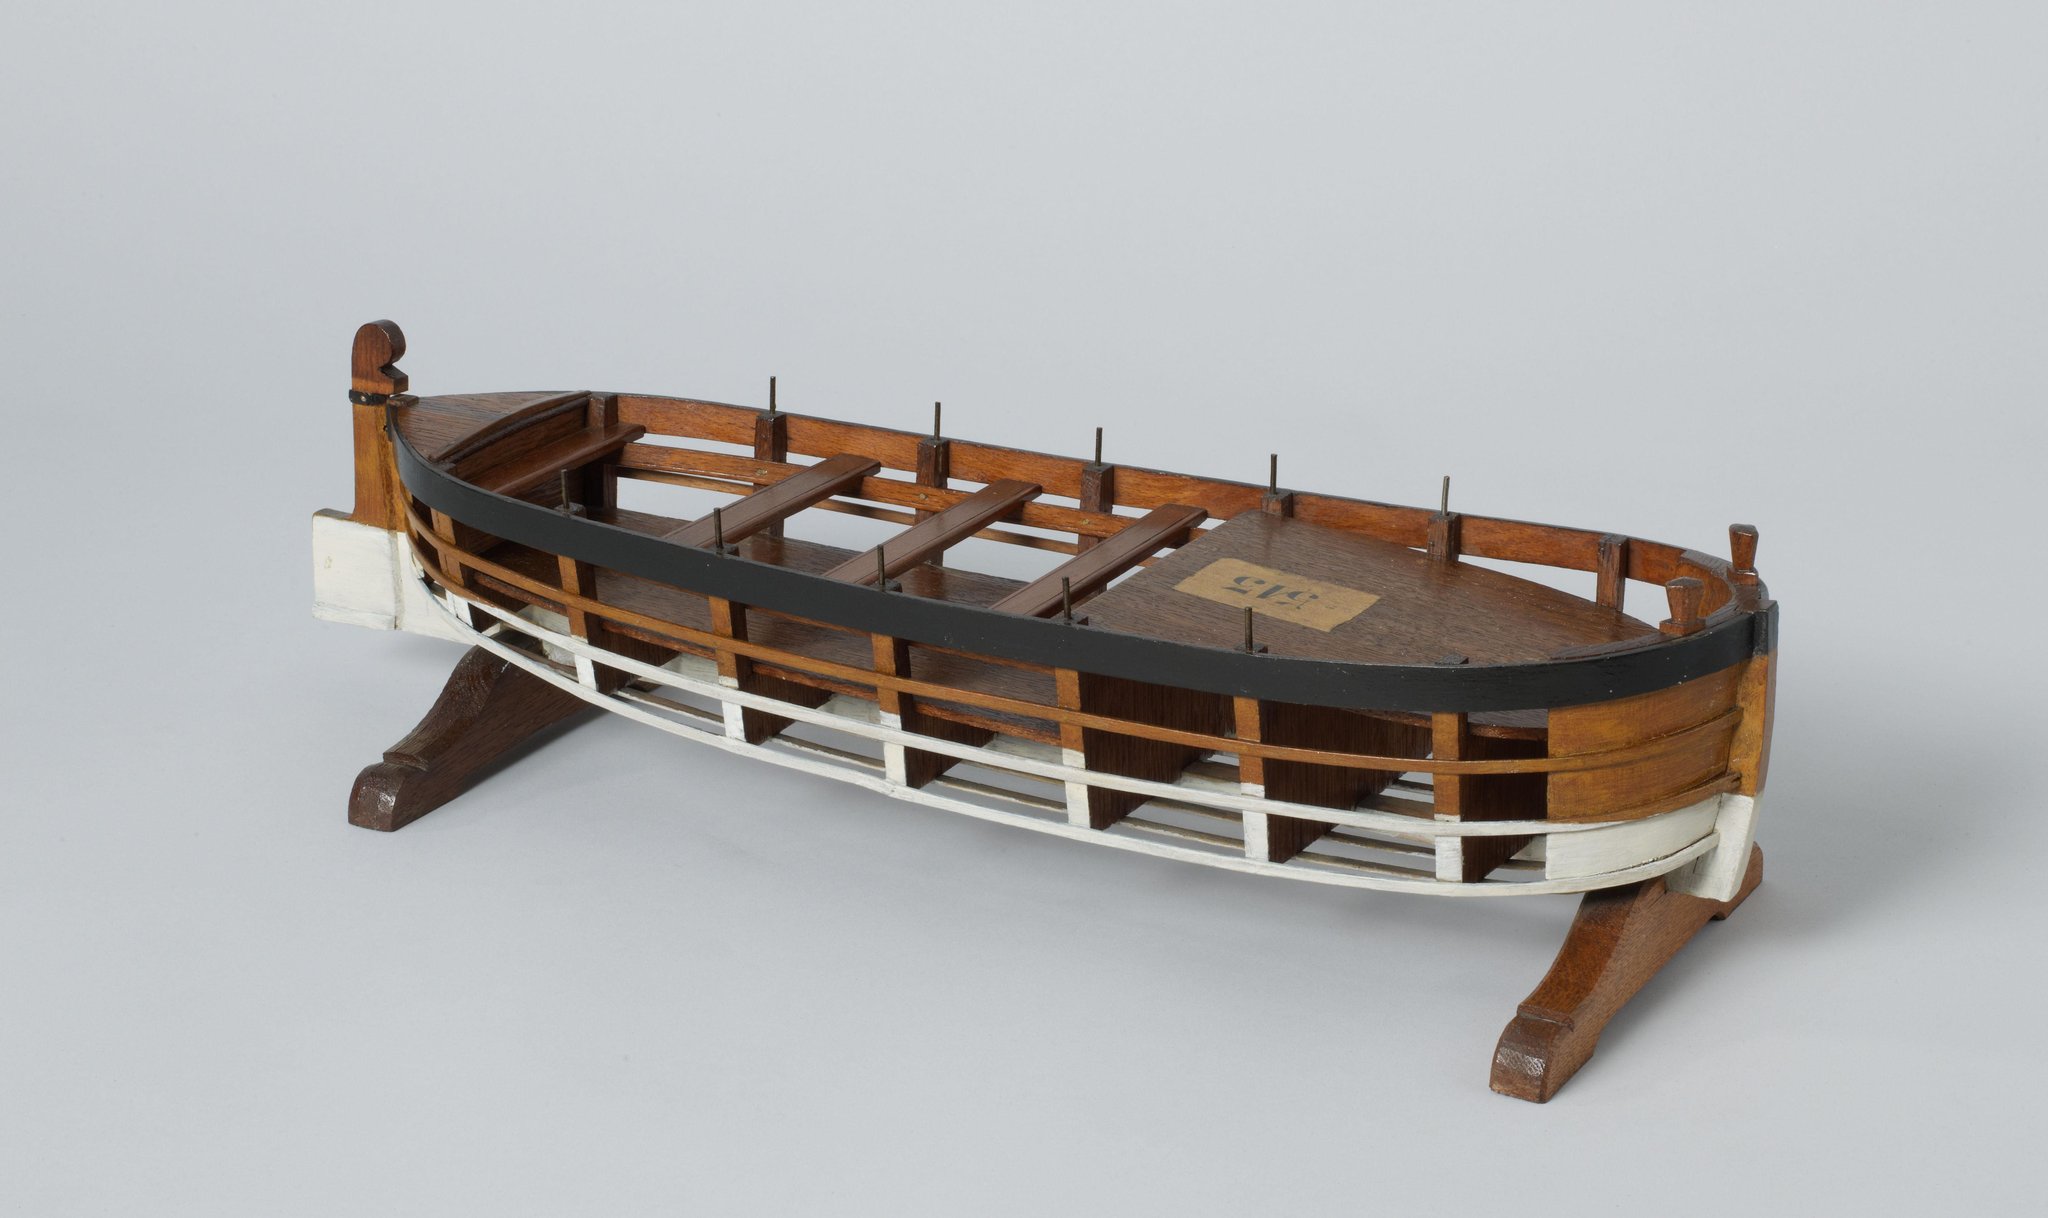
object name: builder's model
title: Model of an Oared Landing Craft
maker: william may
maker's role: kapitein-ter-zee, scheepsbouwer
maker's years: 1725-1807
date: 1785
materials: brass, wood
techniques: polychromy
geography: amsterdam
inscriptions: label, on the deck: ‘513’ former inventory label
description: Gepolychromeerd mallenmodel op steunen, met senten in plaats van dichte huid. Het is een spitsgat platbodem met rechte steven, de zeeg naar voren oplopend; eenvoudig roer waarvan de helmstok ontbreekt. Het model heeft een grote, naar voren aflopende voorplecht, die als geschutstelling dienst deed. Achter dit dek vier losse doften met daaronder een verhoogde vloer. Op het dolboord tien roeipennen.